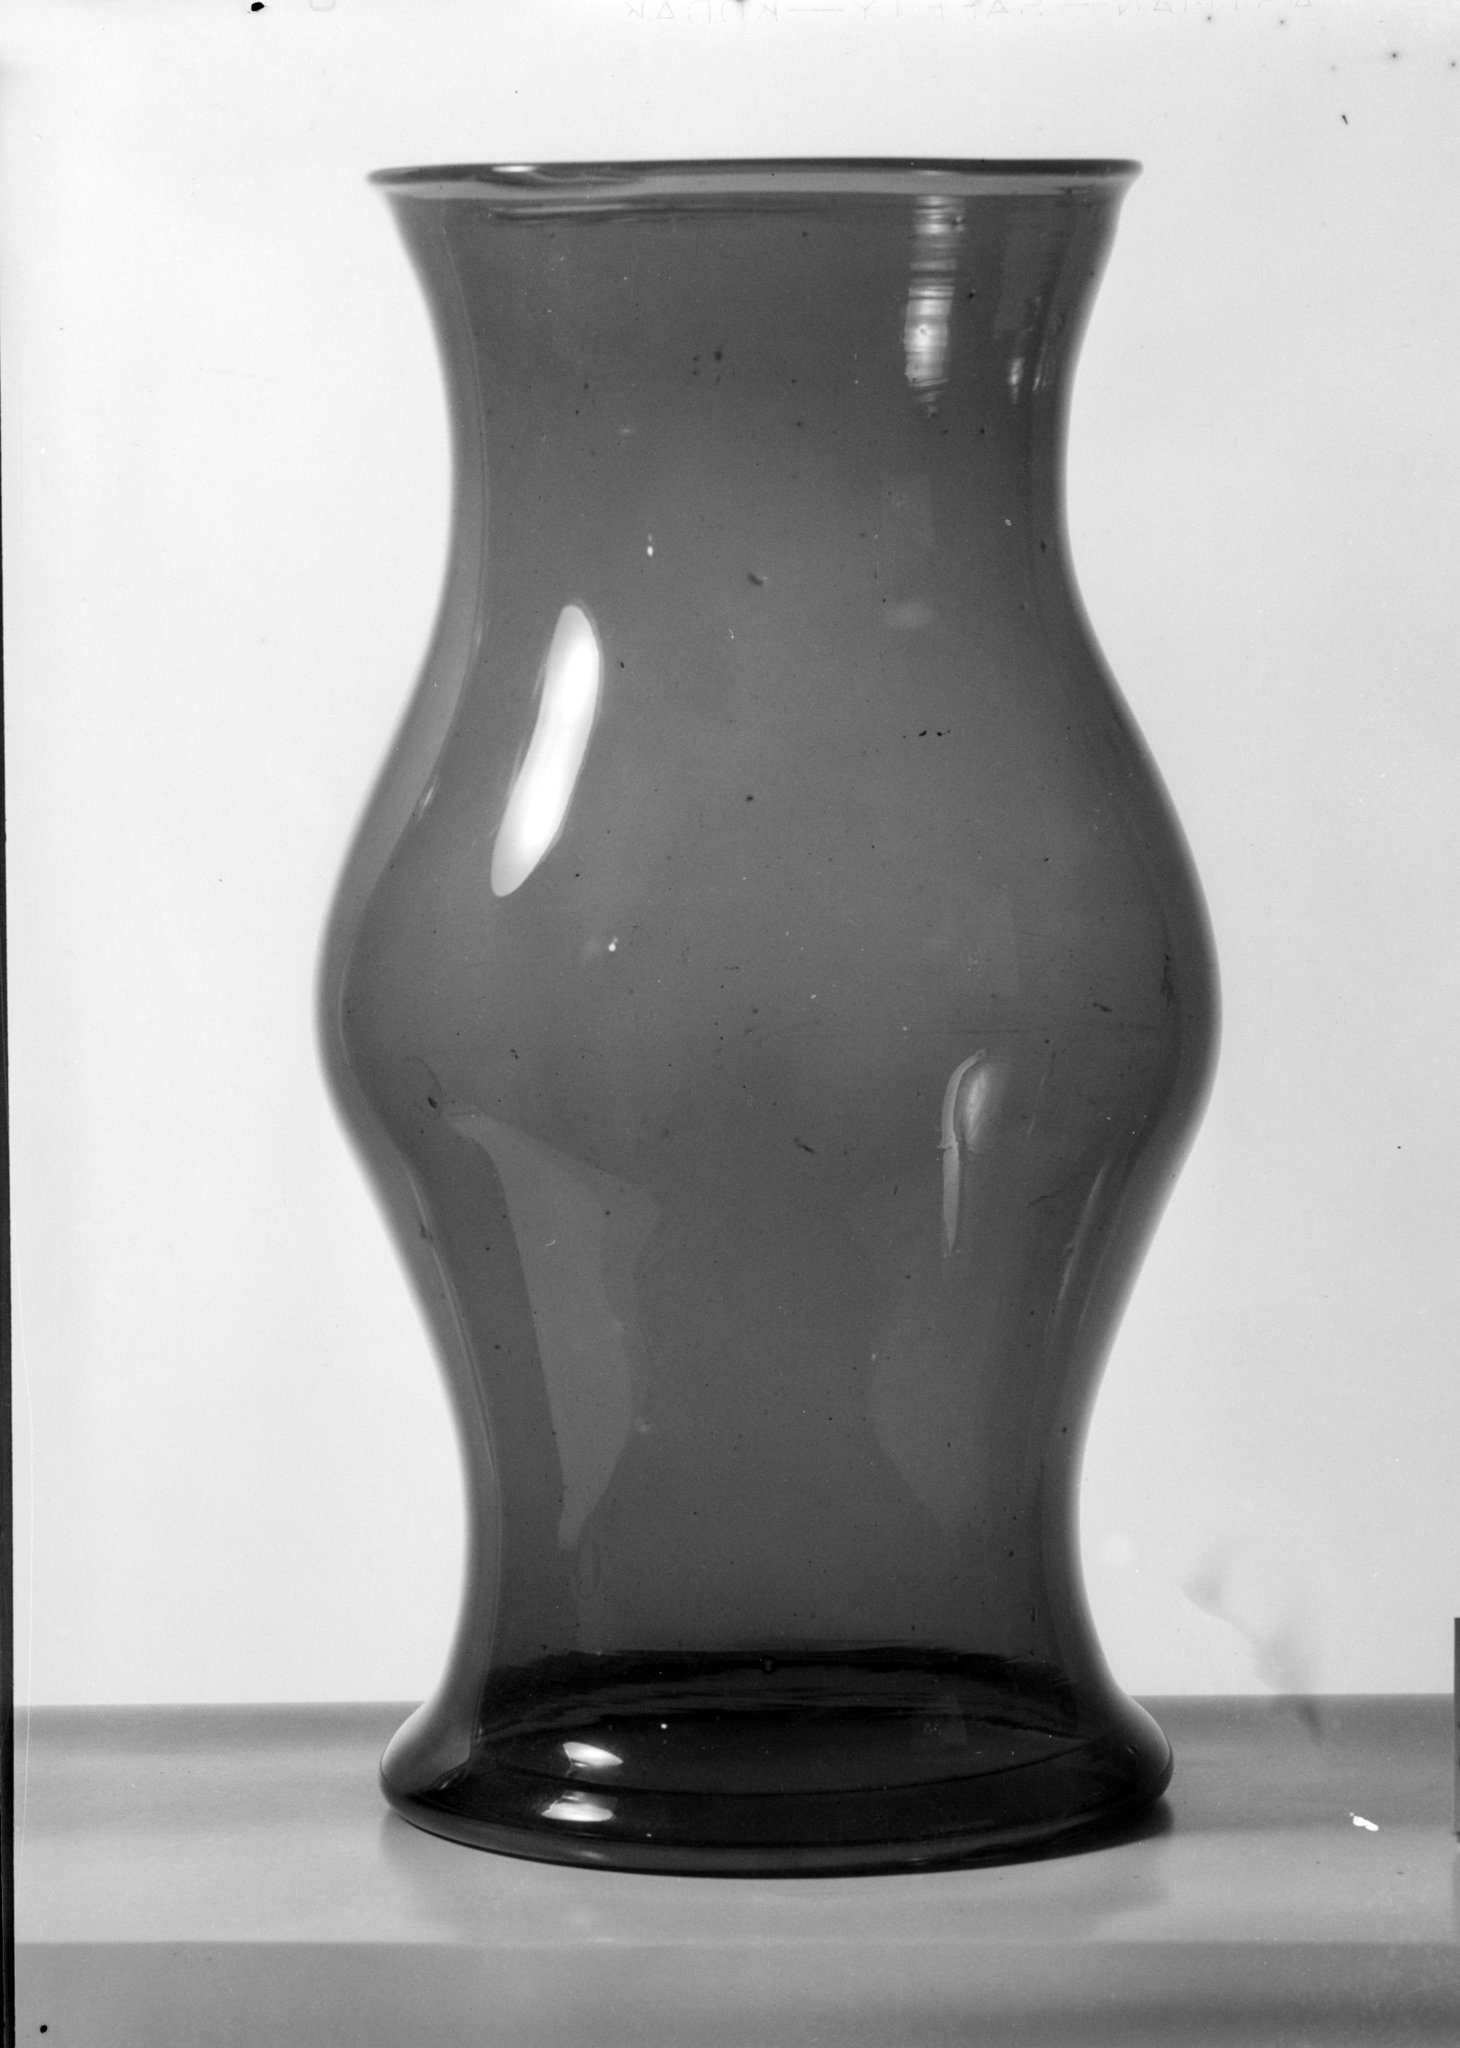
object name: hurricane shade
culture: american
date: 1800-1830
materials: gemstone, glass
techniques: glassblowing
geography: united states